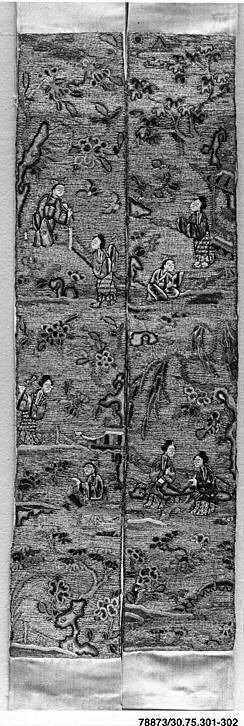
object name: sleeve band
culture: chinese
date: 1801-1900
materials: metal thread, silk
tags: women